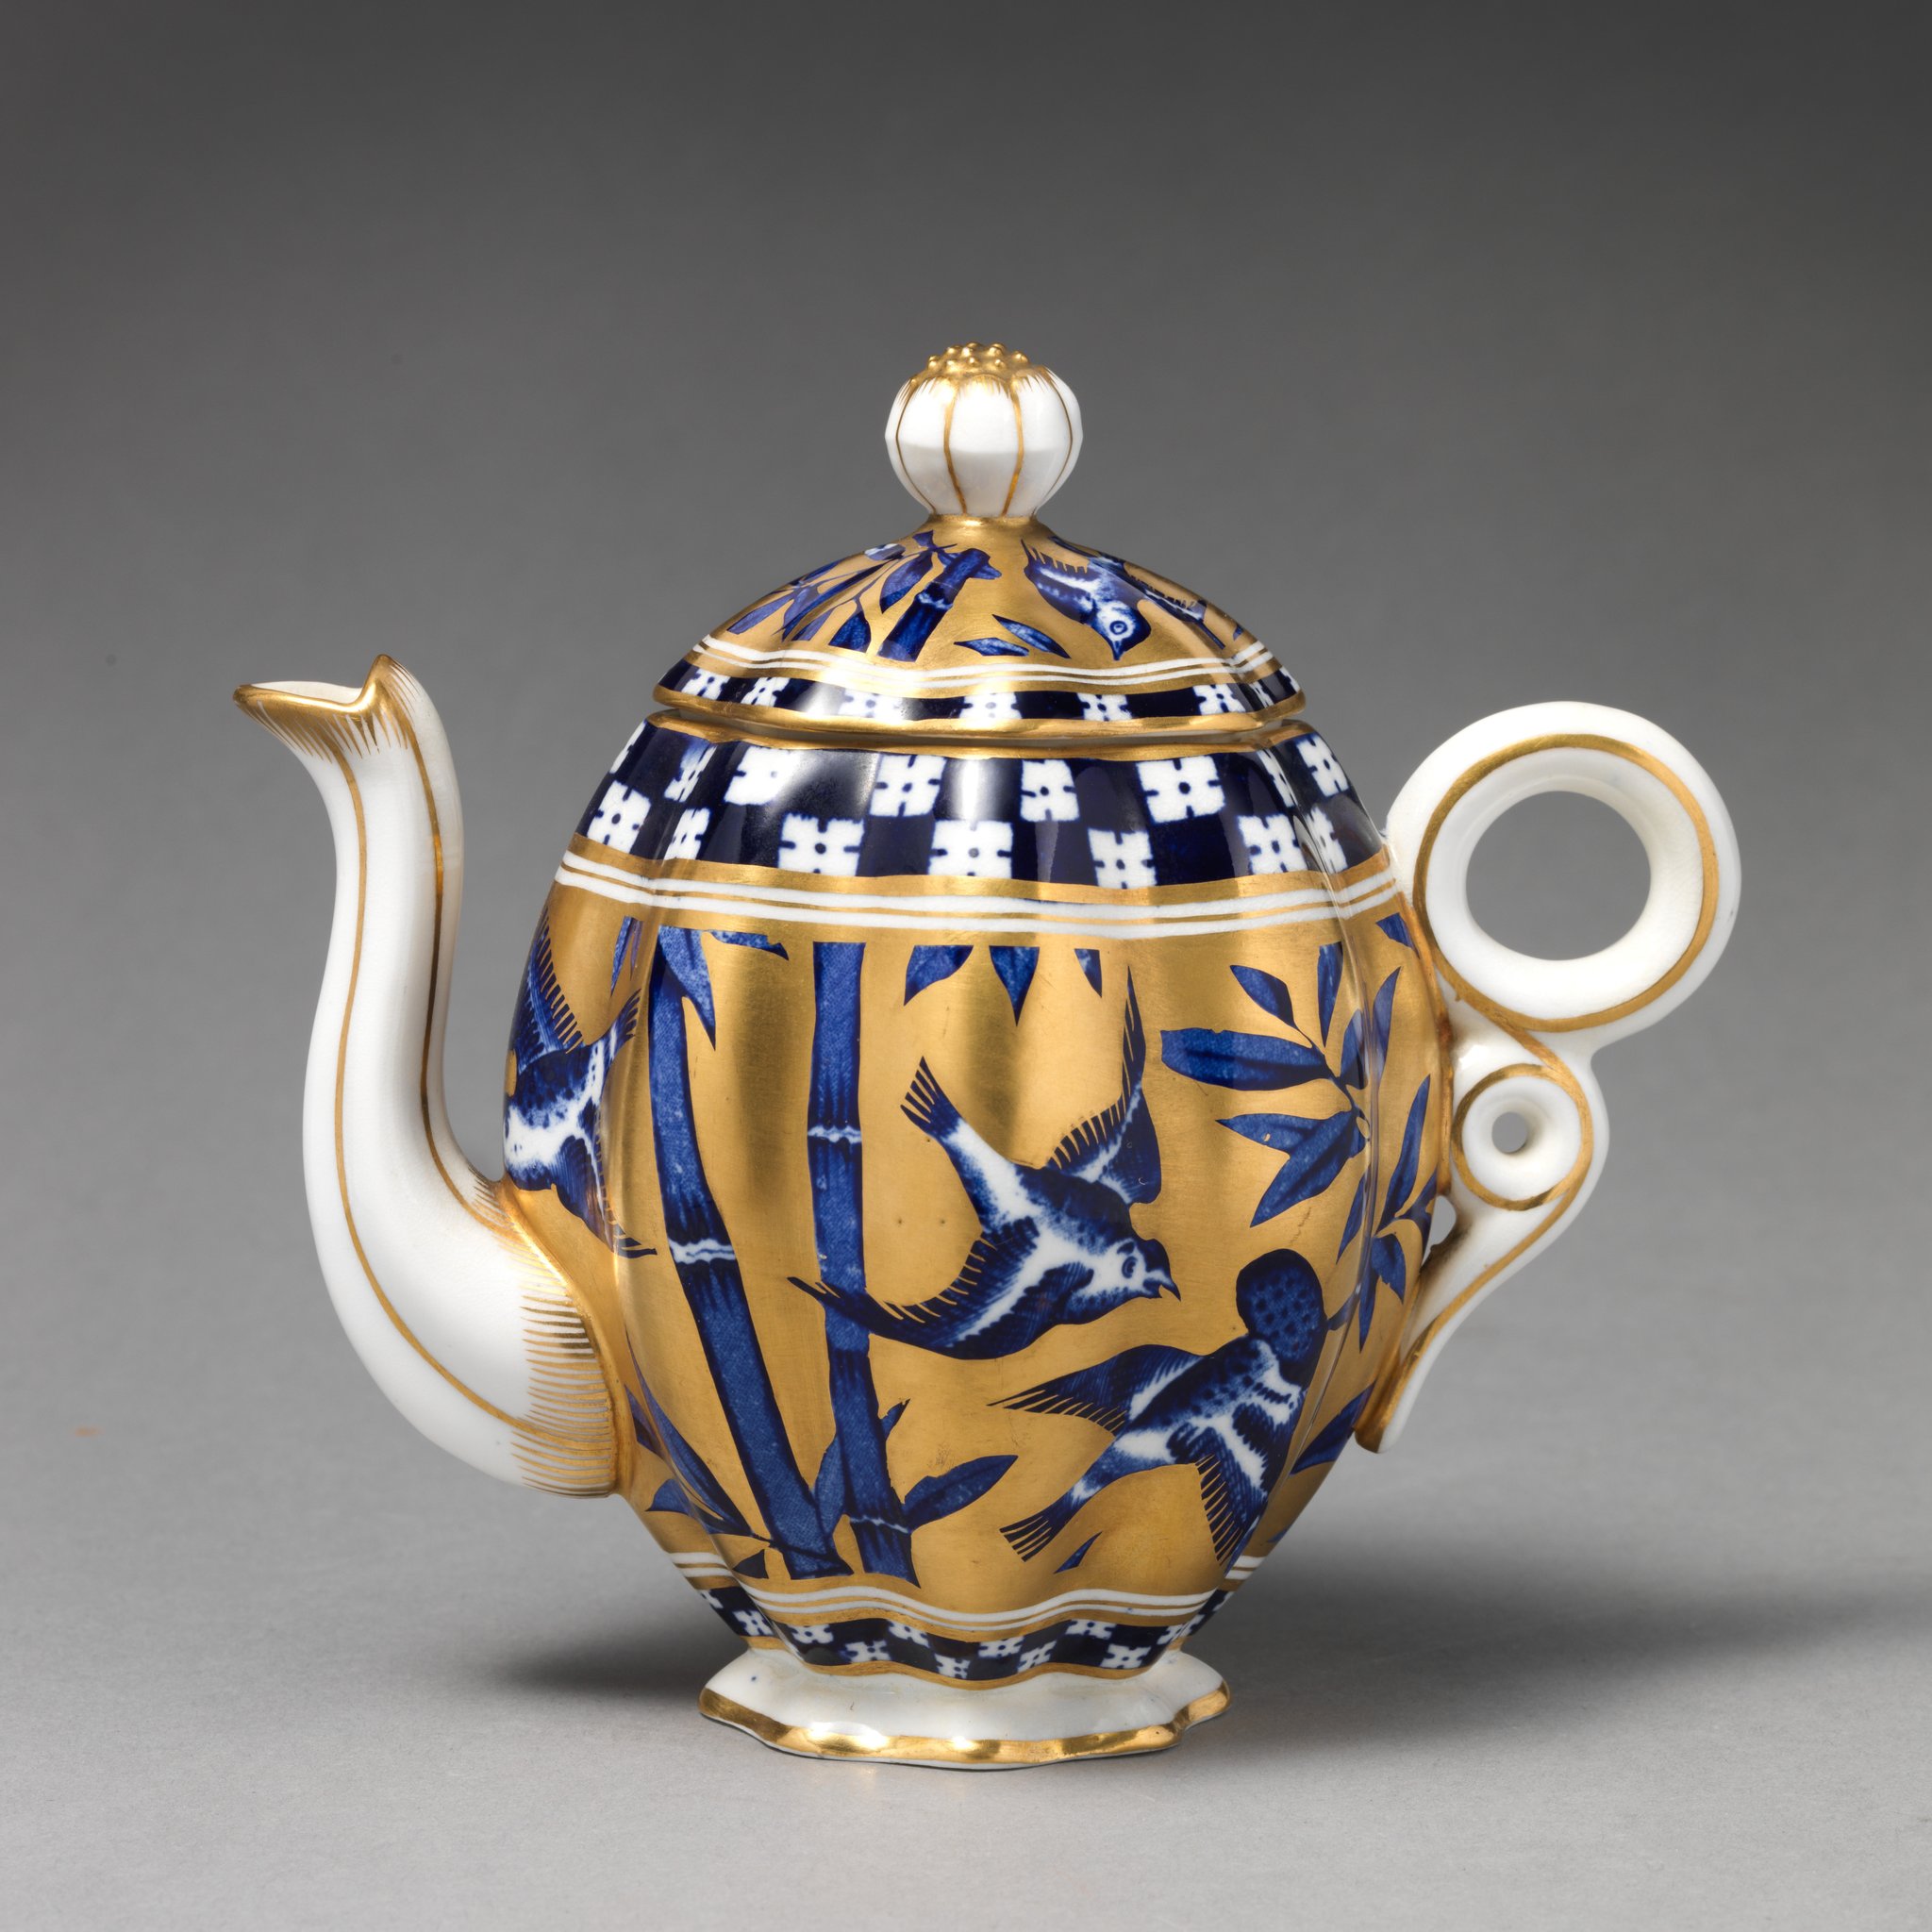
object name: teapot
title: Small teapot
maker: coalport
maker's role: maker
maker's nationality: british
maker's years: 1794-1926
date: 1891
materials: porcelain